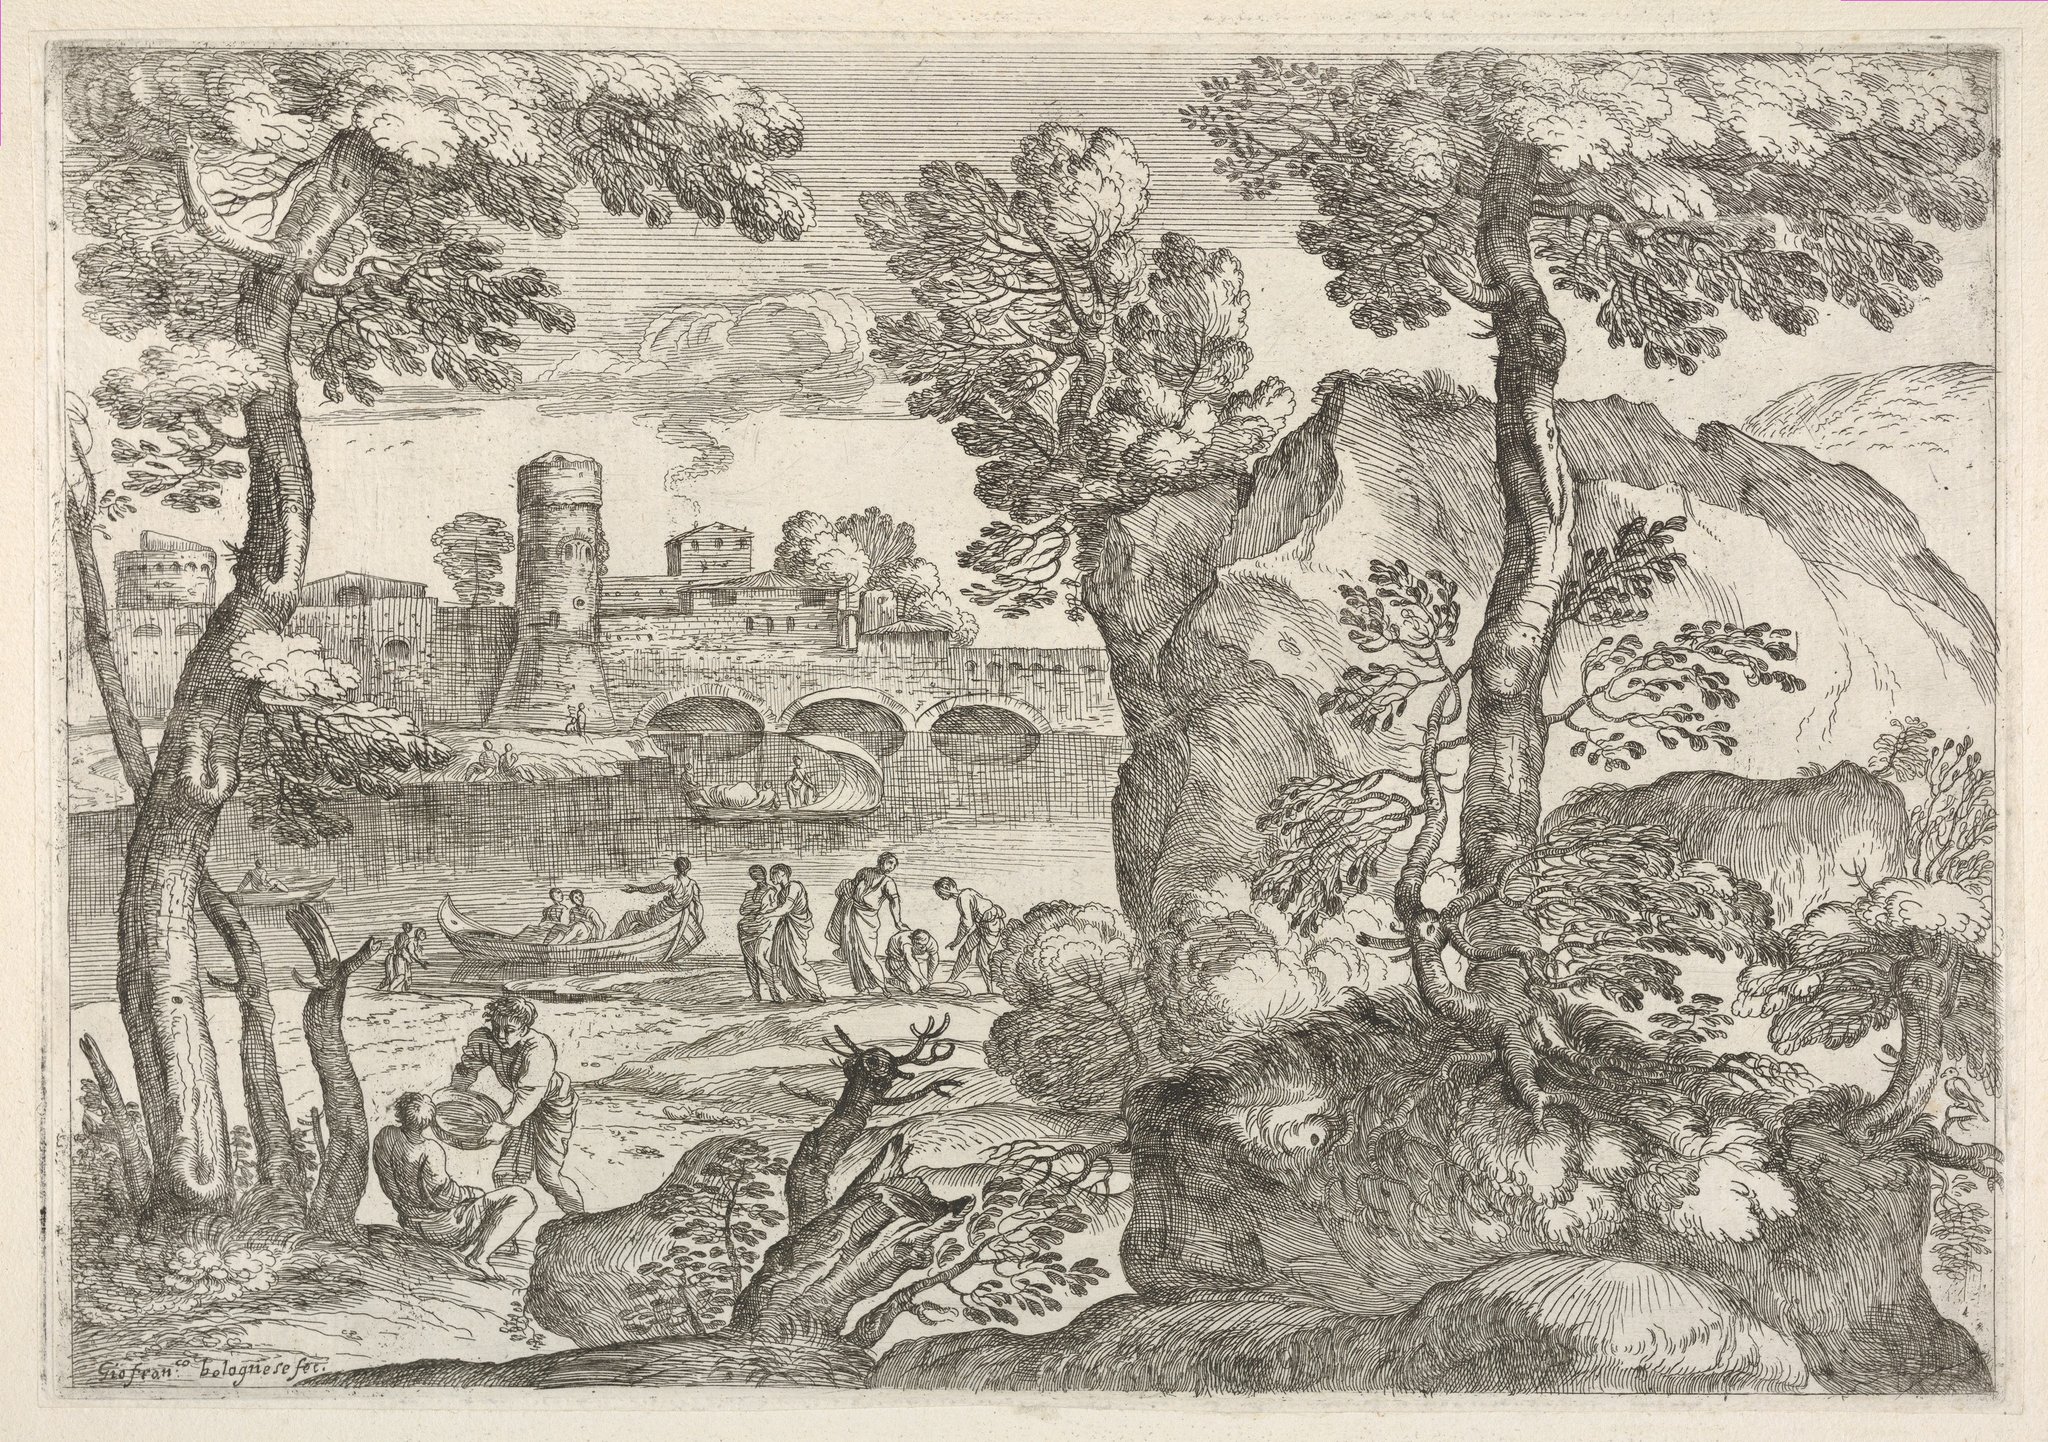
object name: print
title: Landscape with bridge traversing a river occupied with three small boats, one of which is encroaching the near river bank, in the foreground are a rocky outcrop and a figure lifting a circular dish above a seated figure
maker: giovanni francesco grimaldi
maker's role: artist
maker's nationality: italian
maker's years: 1606-1680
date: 1626-1680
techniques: etching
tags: bridges,rivers,landscapes,trees,boats